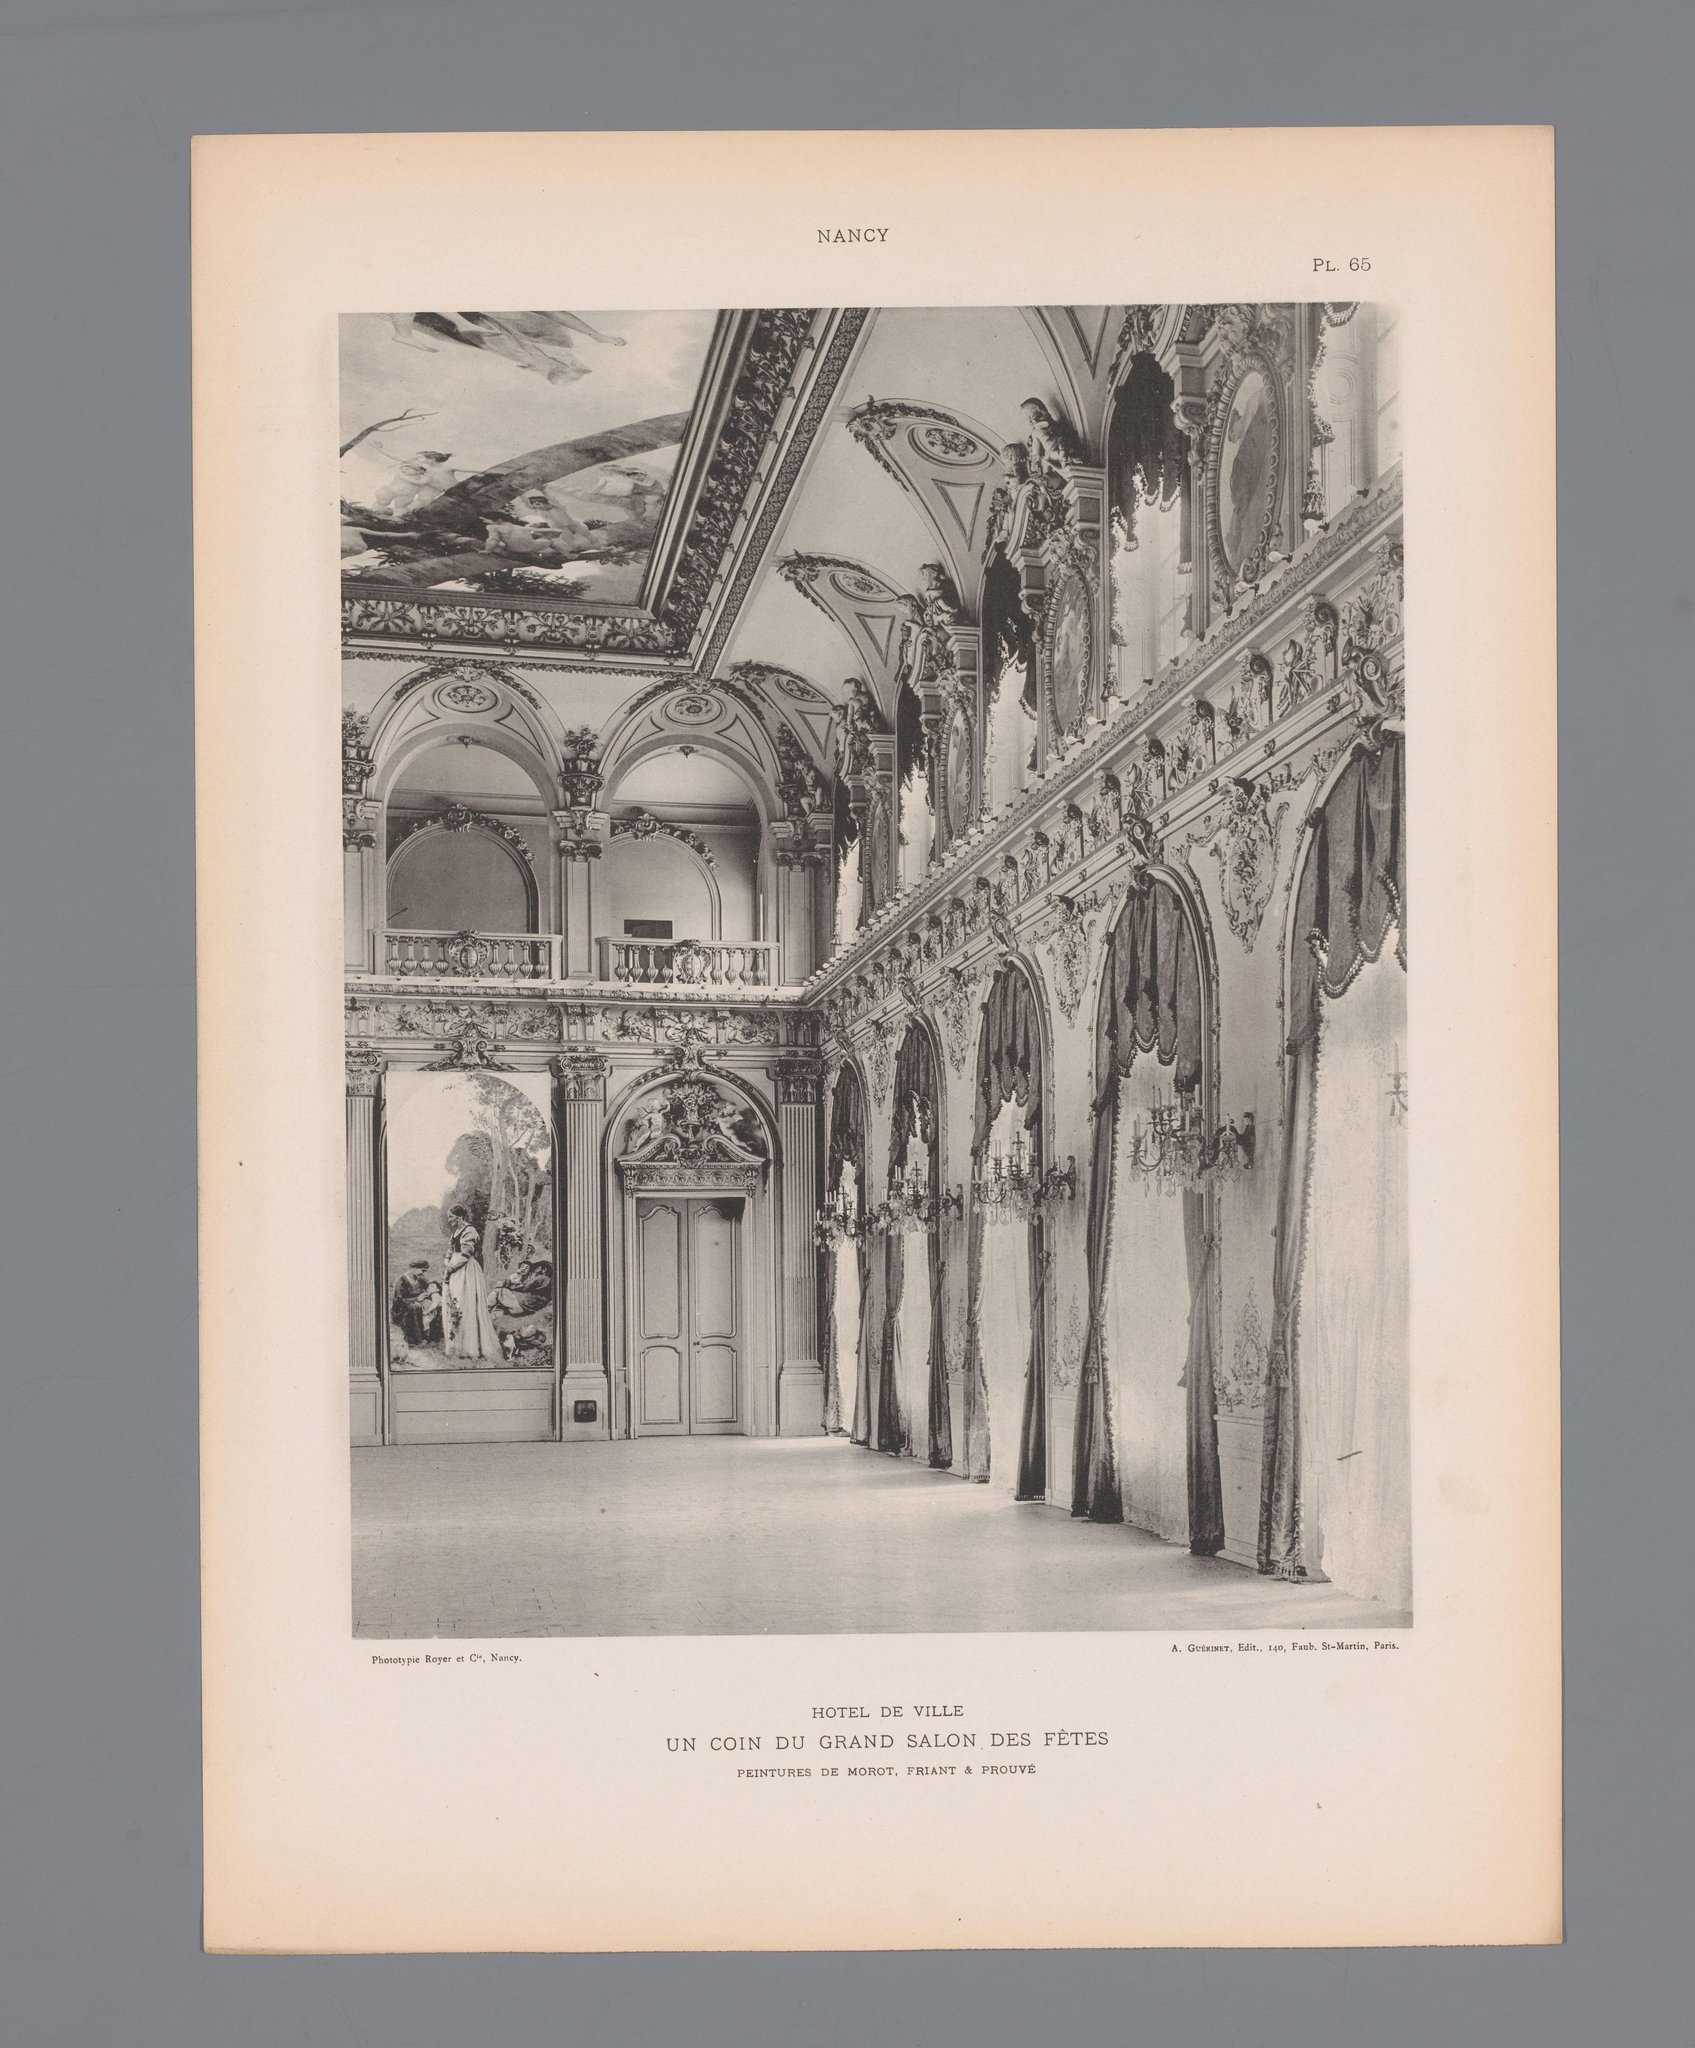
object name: photomechanical print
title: Feestzaal in het stadhuis te Nancy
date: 1891-1896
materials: paper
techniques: photograph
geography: nancy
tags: townhall, interior ~ representation of a building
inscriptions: inscription: ‘Hotel de ville/ Un coin du grand salon de fêtes/ peintures de Morot, Friant & Prouvé’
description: Deze prent maakt deel uit van een omslag met 103 prenten op 101 bladen en een titelblad.